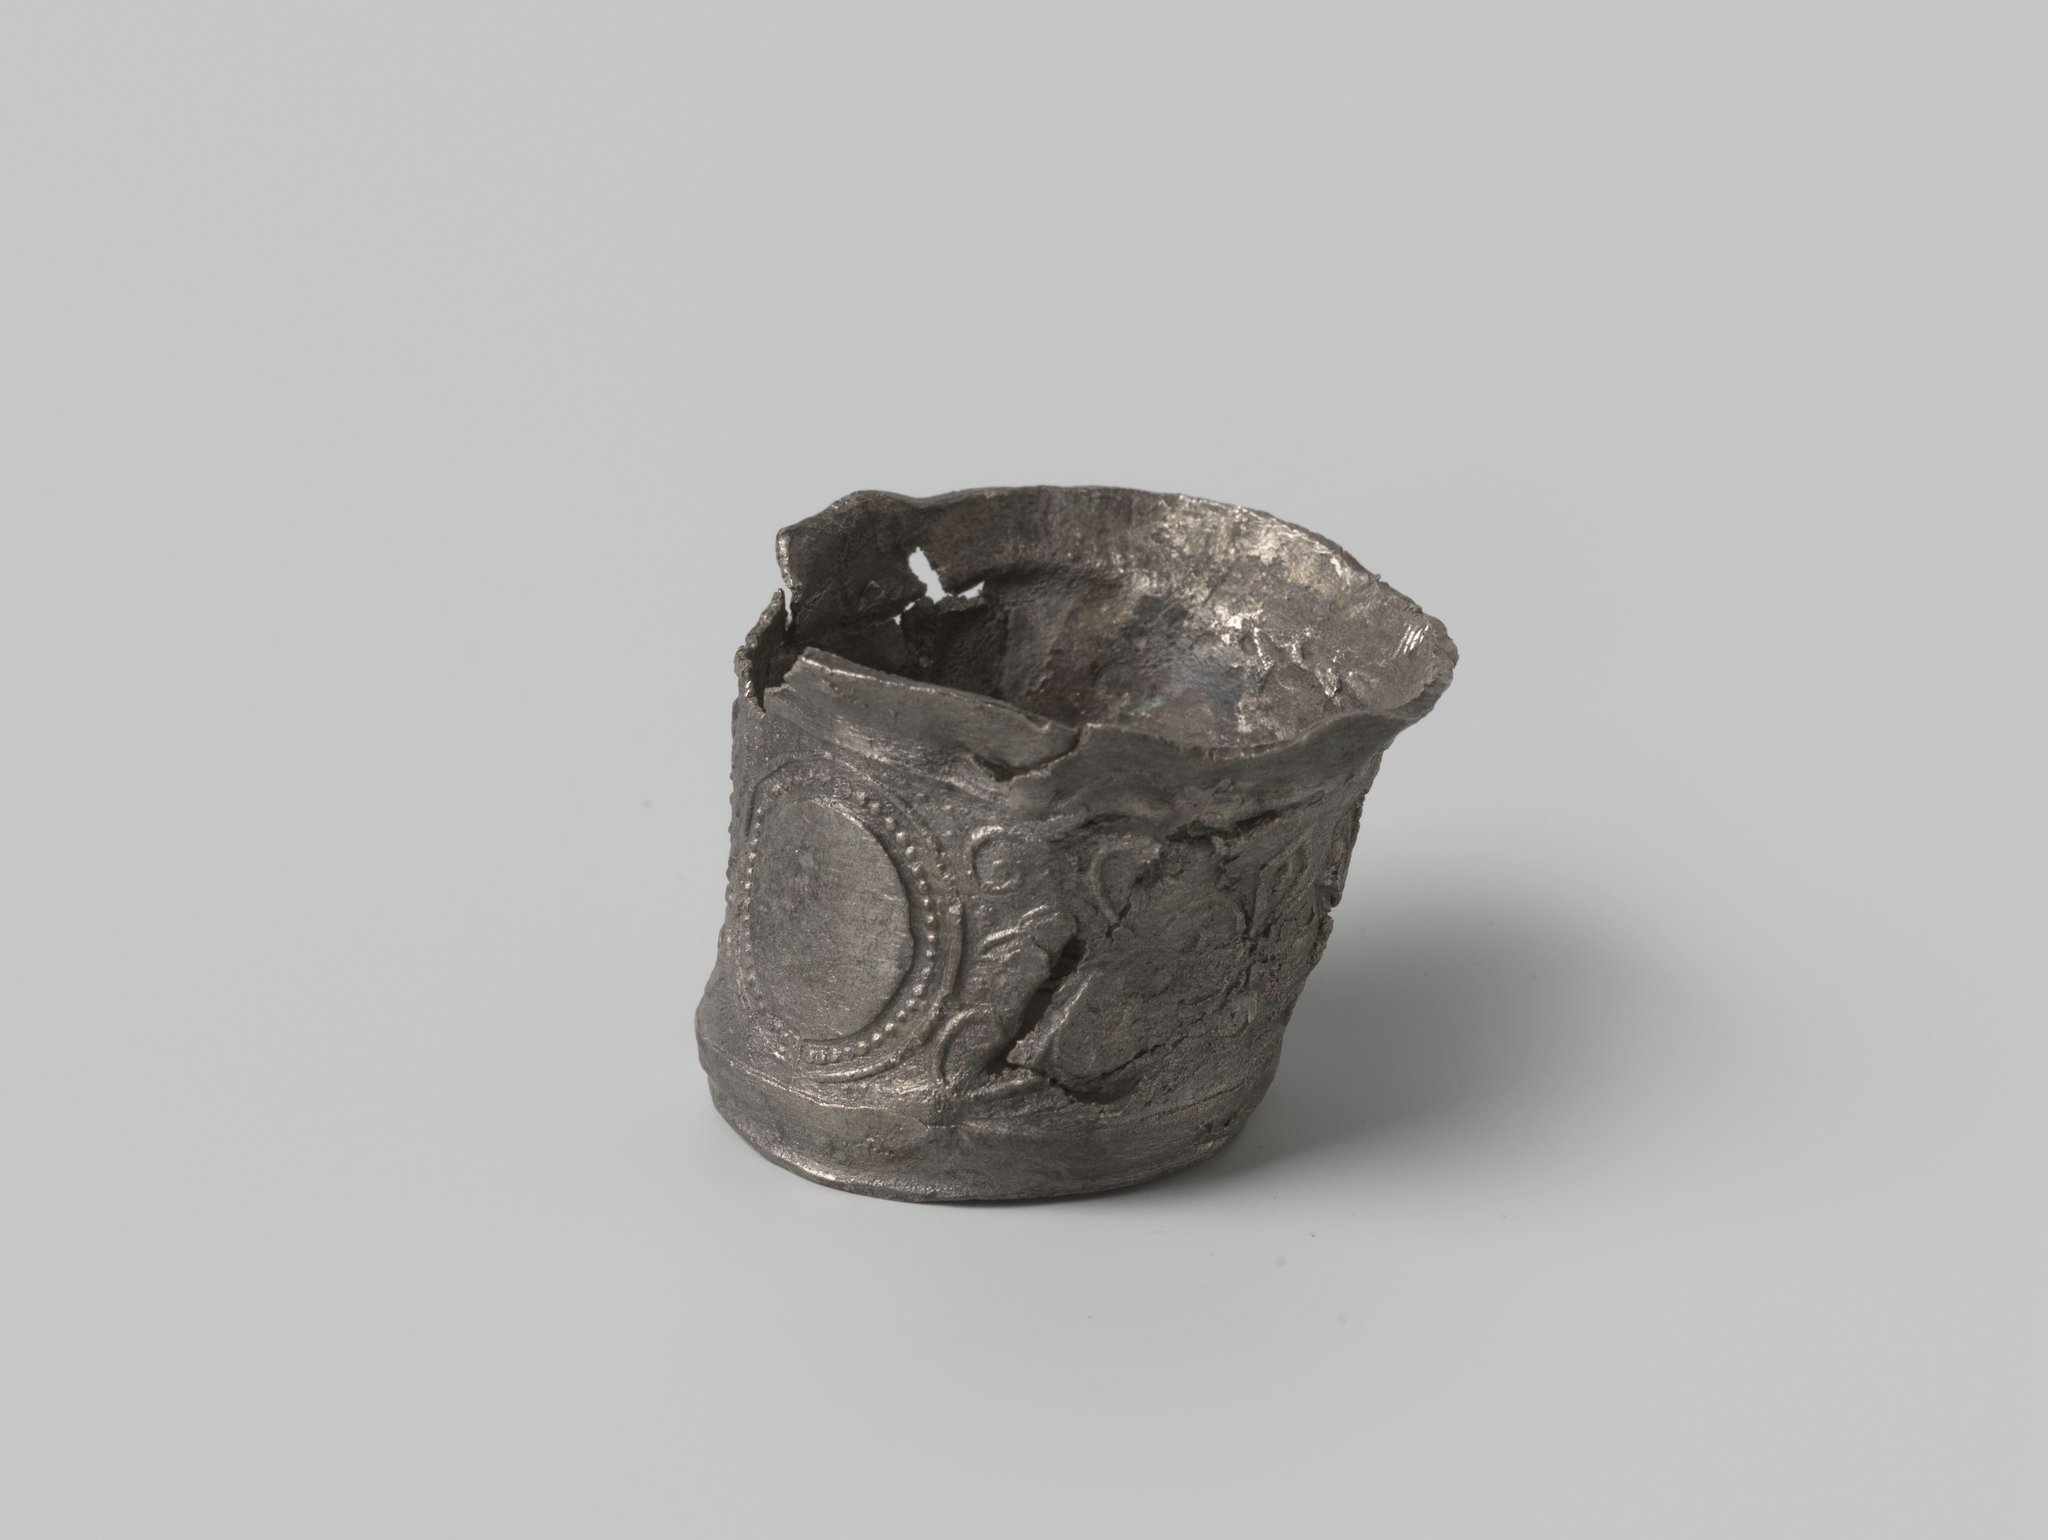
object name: cup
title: Beker uit het wrak van de Oost-Indiëvaarder Hollandia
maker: Anonymous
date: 1700-1743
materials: tin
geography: netherlands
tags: verenigde oostindische compagnie, hollandia (schip), annet